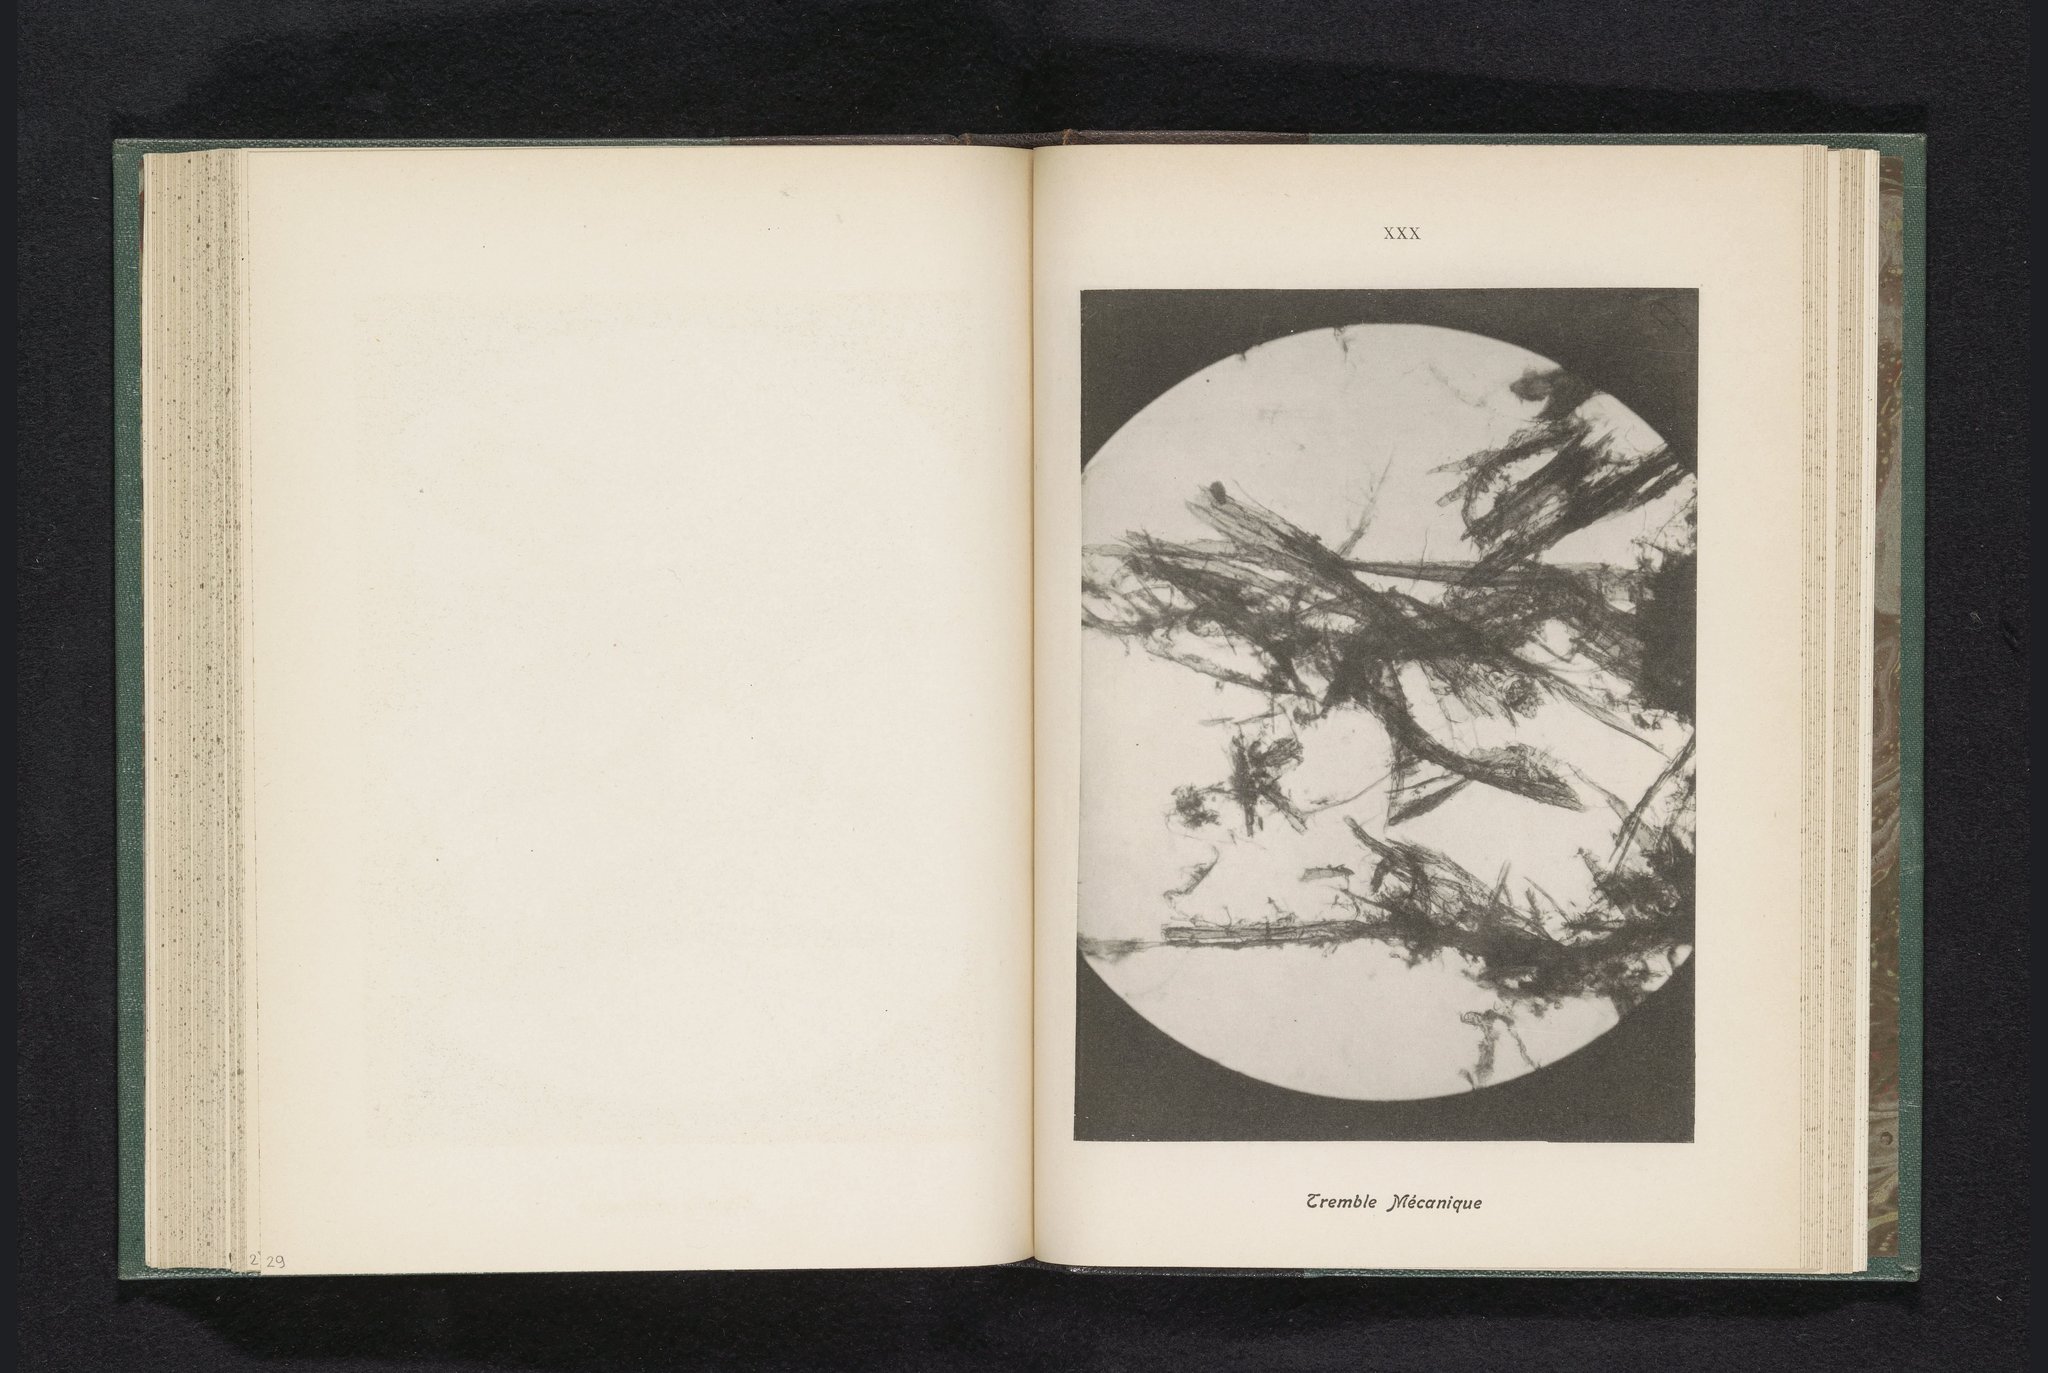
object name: page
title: Micro-opname van de vezels van vermoedelijk een esp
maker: Anonymous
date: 1890-1900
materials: paper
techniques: photograph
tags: microscope (+ scientific research)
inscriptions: number: ‘XXX’